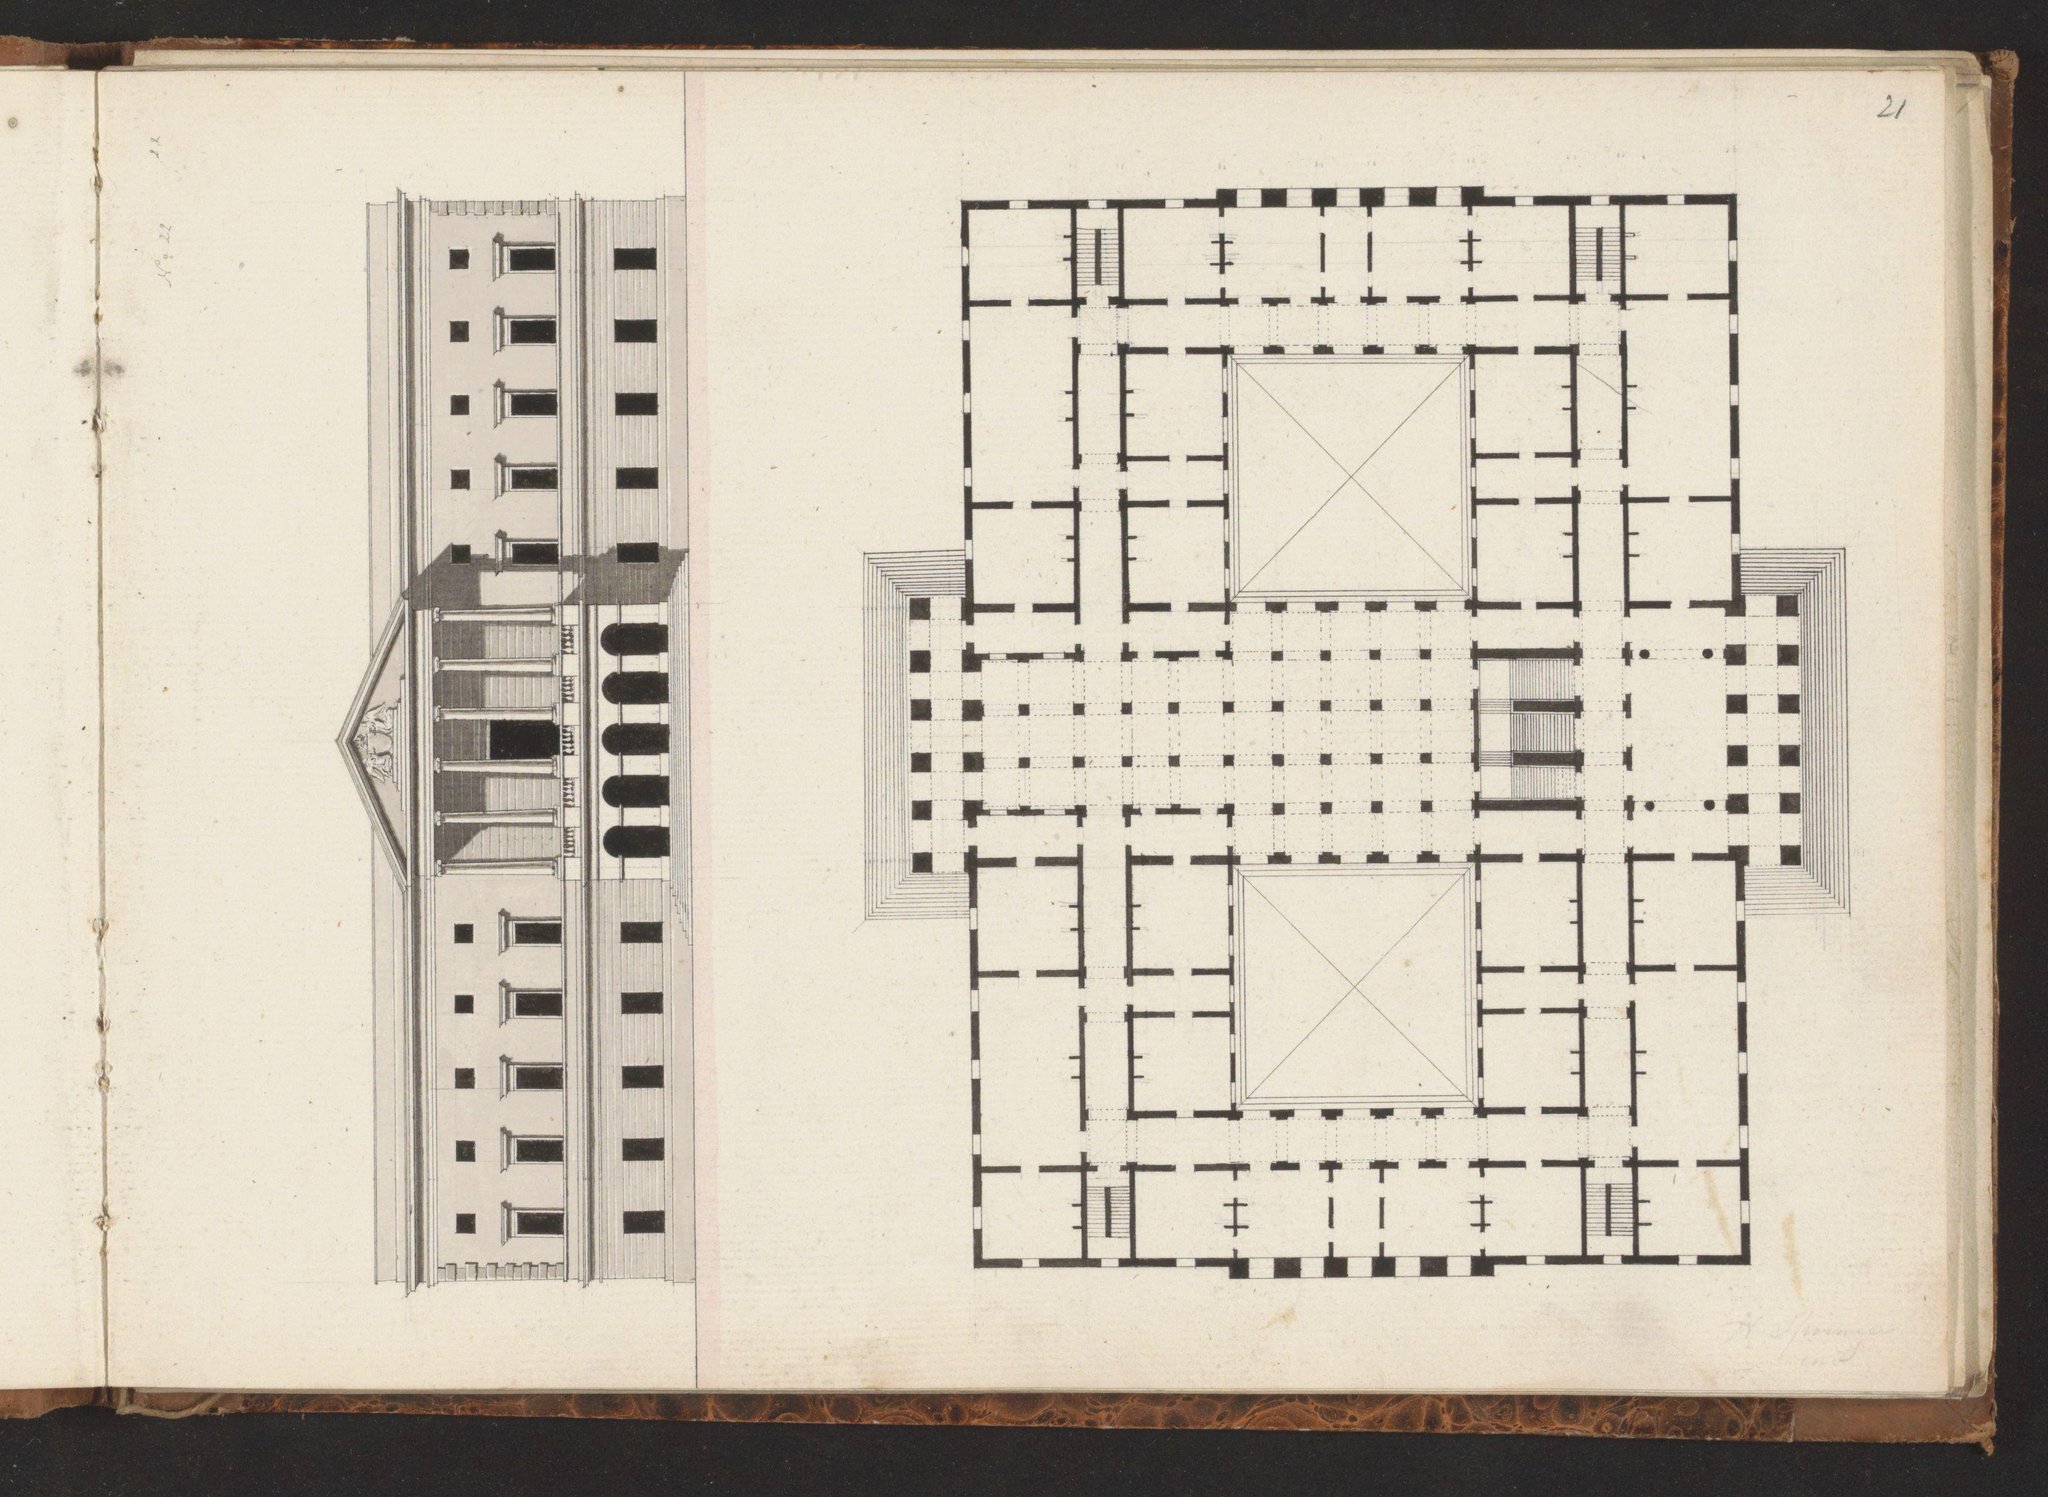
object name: sketchbook leaf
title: Plattegrond en voorgevel van een villa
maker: willem springer jr.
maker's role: draughtsman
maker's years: 1815-1907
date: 1825-1907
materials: ink, paper, pencil, watercolor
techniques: brush, pen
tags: villa, façade (of house or building), plan ~ architecture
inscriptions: number: ‘No 22/ 22’, name: ‘W Springer/ [...]’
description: Pagina 21 uit een schetsboek met 86 pagina's.